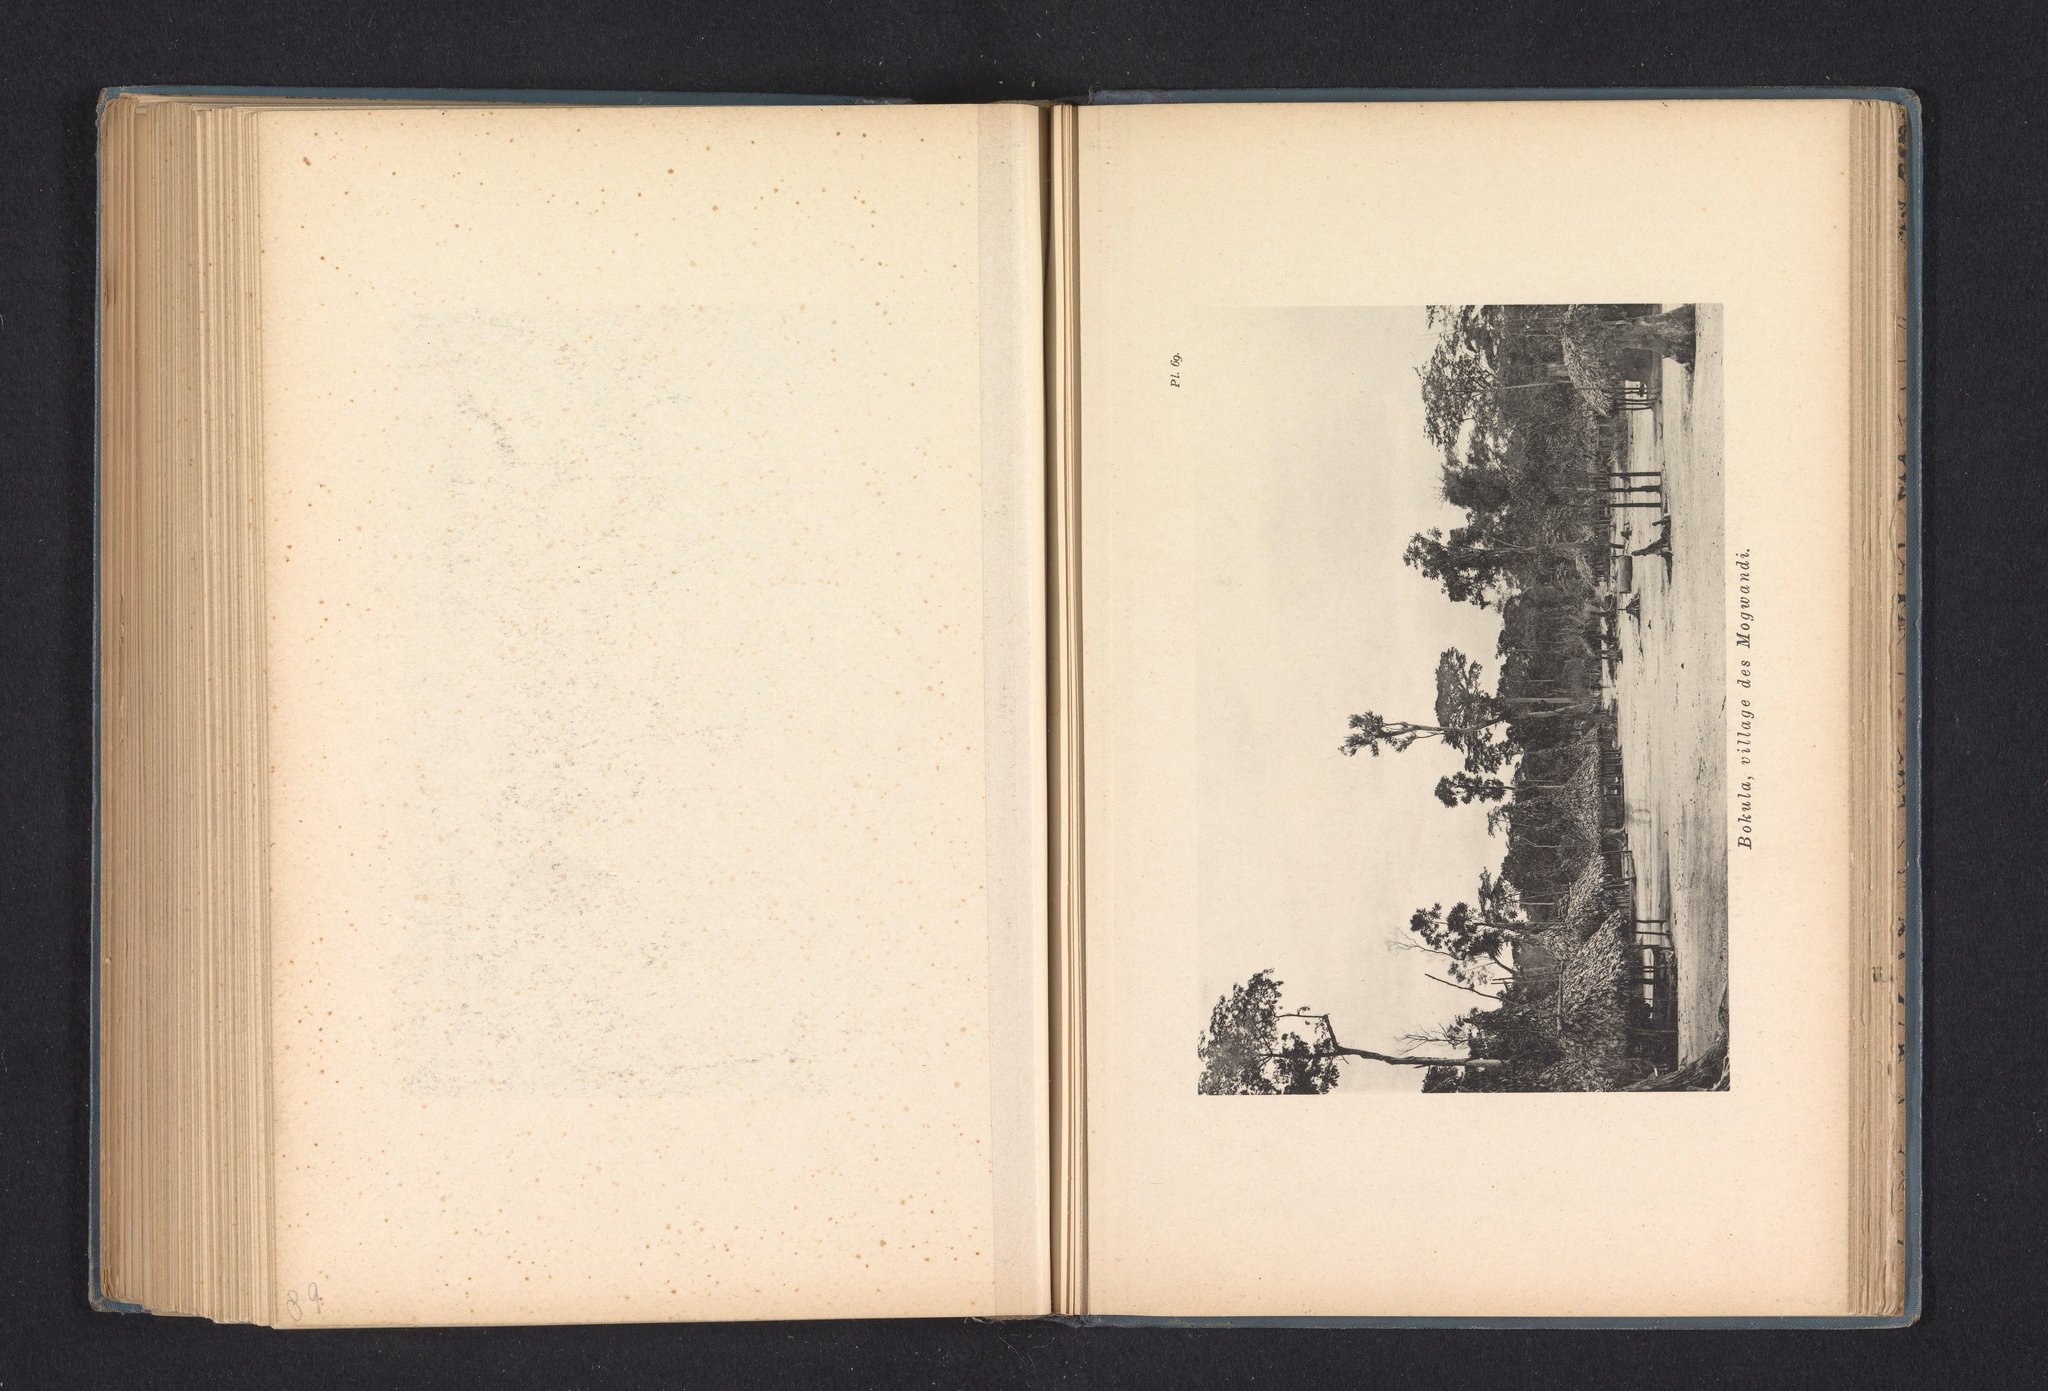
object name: photomechanical print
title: Bokula, village des Mogwandi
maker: franz thonner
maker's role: botanicus, ontdekkingsreiziger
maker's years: 1863-1928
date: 1896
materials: paper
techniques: photograph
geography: bokula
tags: housing, façade (of house or building)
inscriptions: number: ‘Pl. 69.’